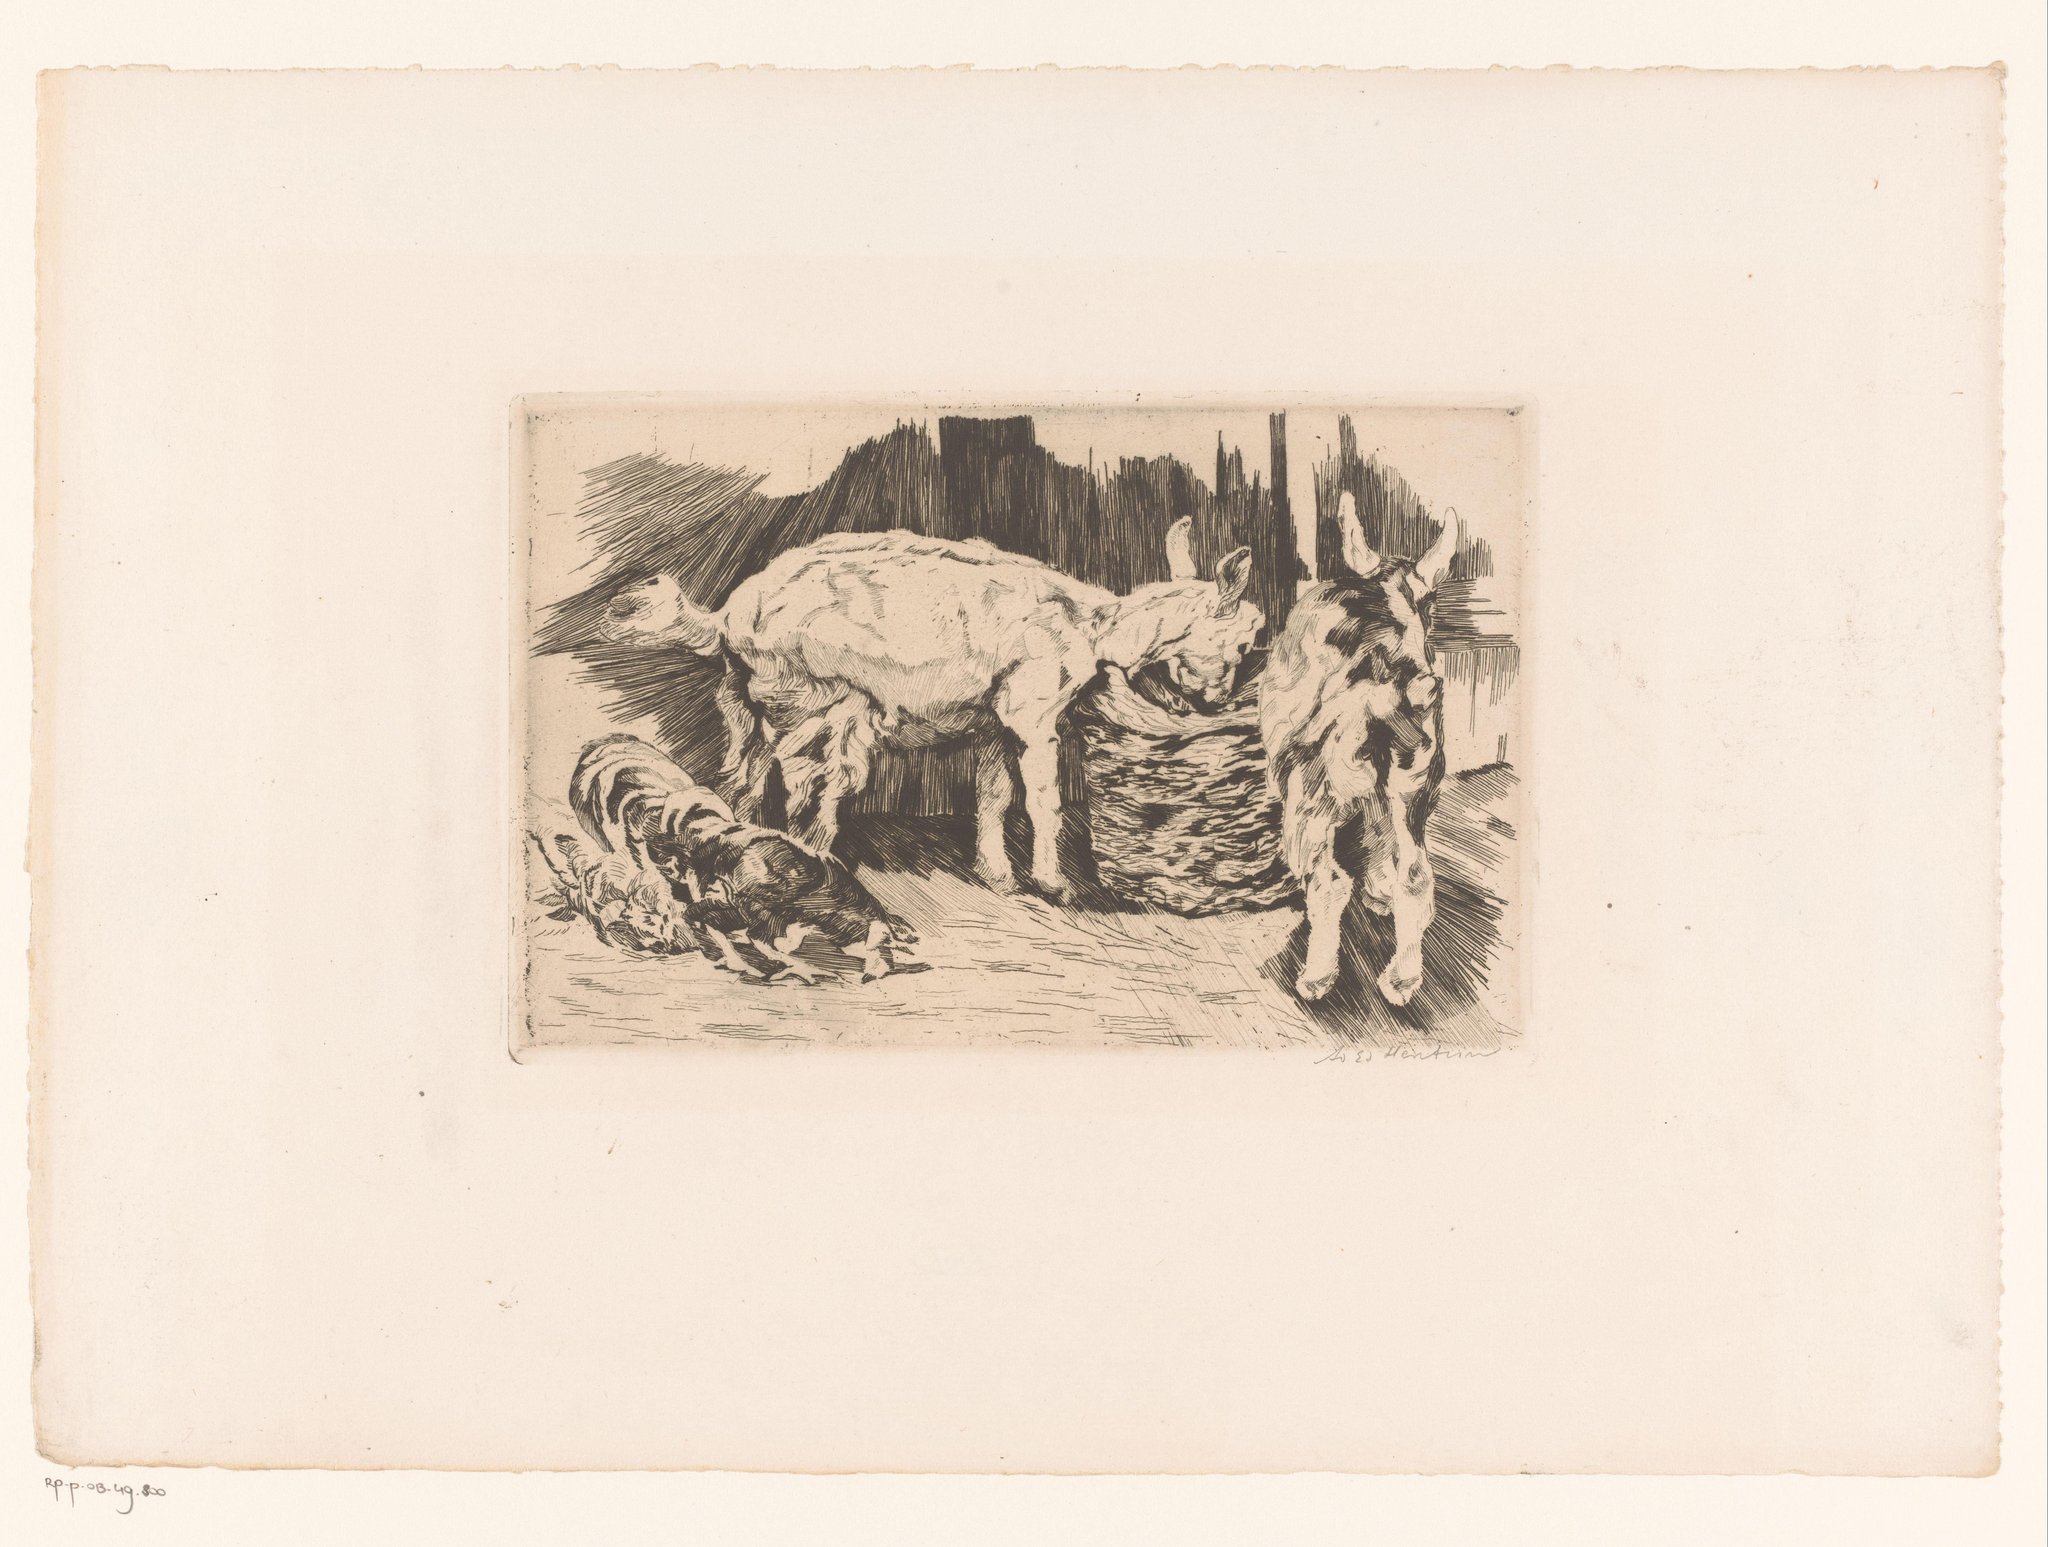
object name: print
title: Twee geiten en een haan bij een mand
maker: adolf eduard herstein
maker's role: print maker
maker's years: 1869-1932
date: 1879-1932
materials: paper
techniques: drypoint, etching, intaglio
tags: fowl (cock, hen, chicken, etc.), goat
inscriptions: collector's mark: Lugt 2228